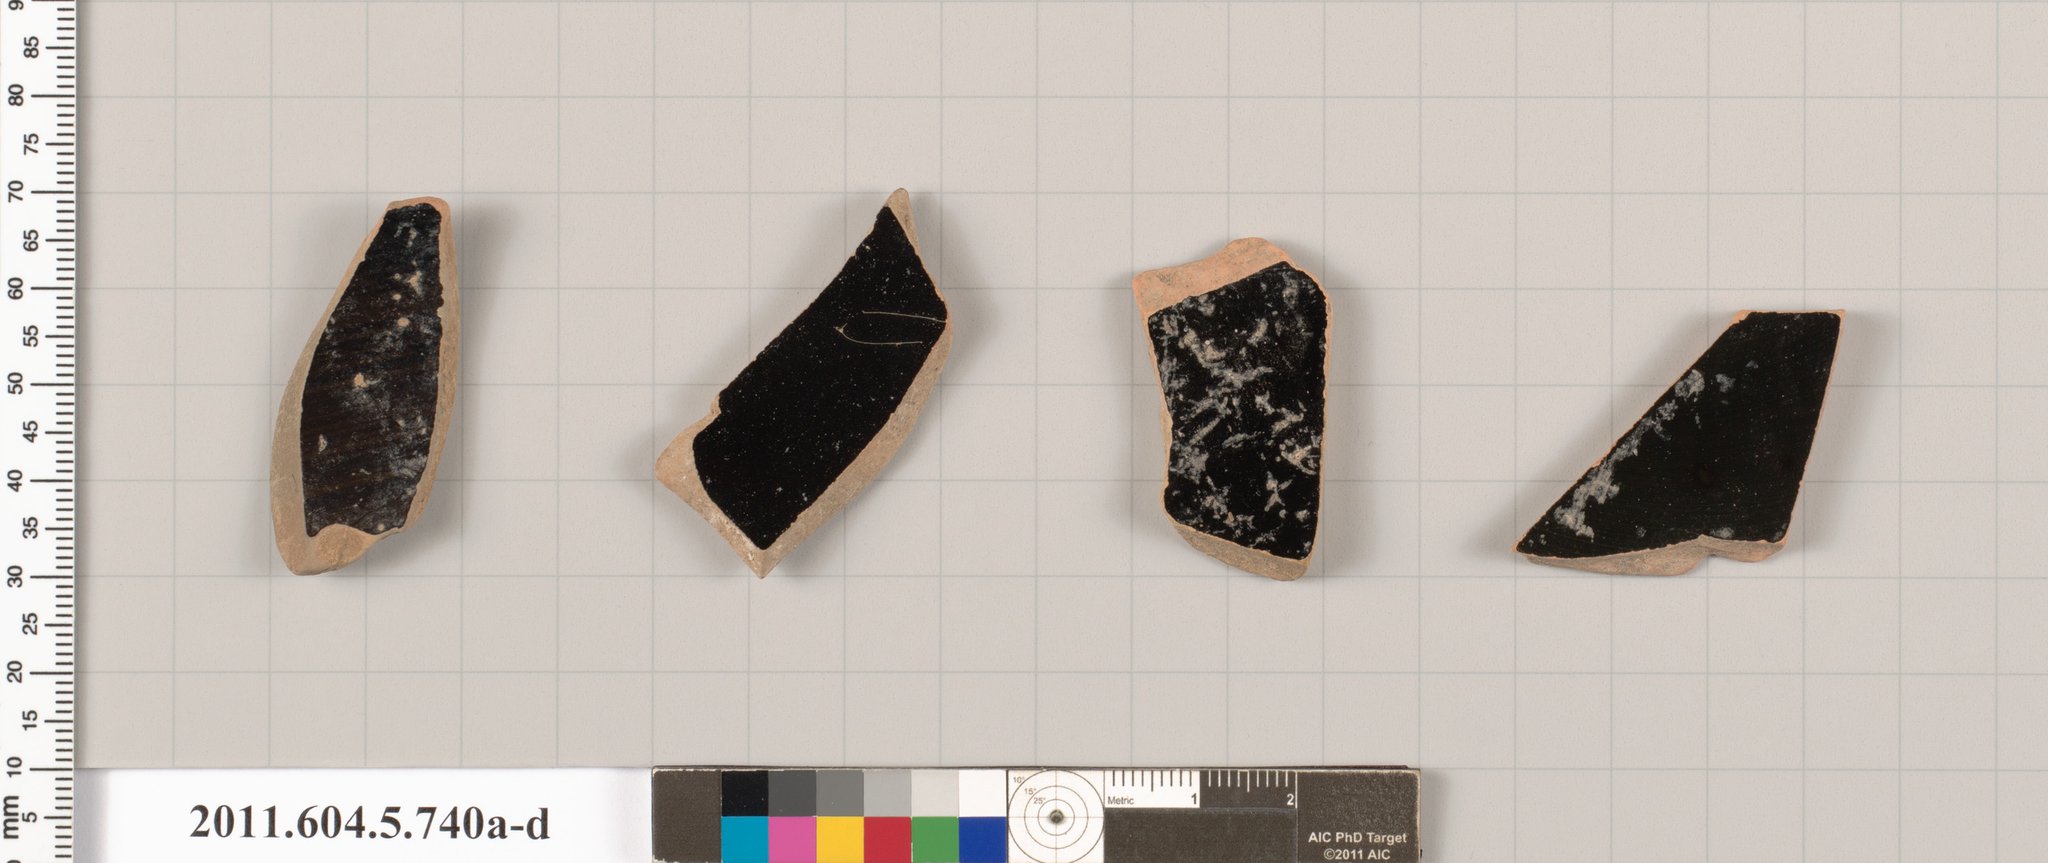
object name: kylix fragment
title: Terracotta fragments of kylikes (drinking cups)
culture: greek, attic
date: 600-401 BCE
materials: terracotta